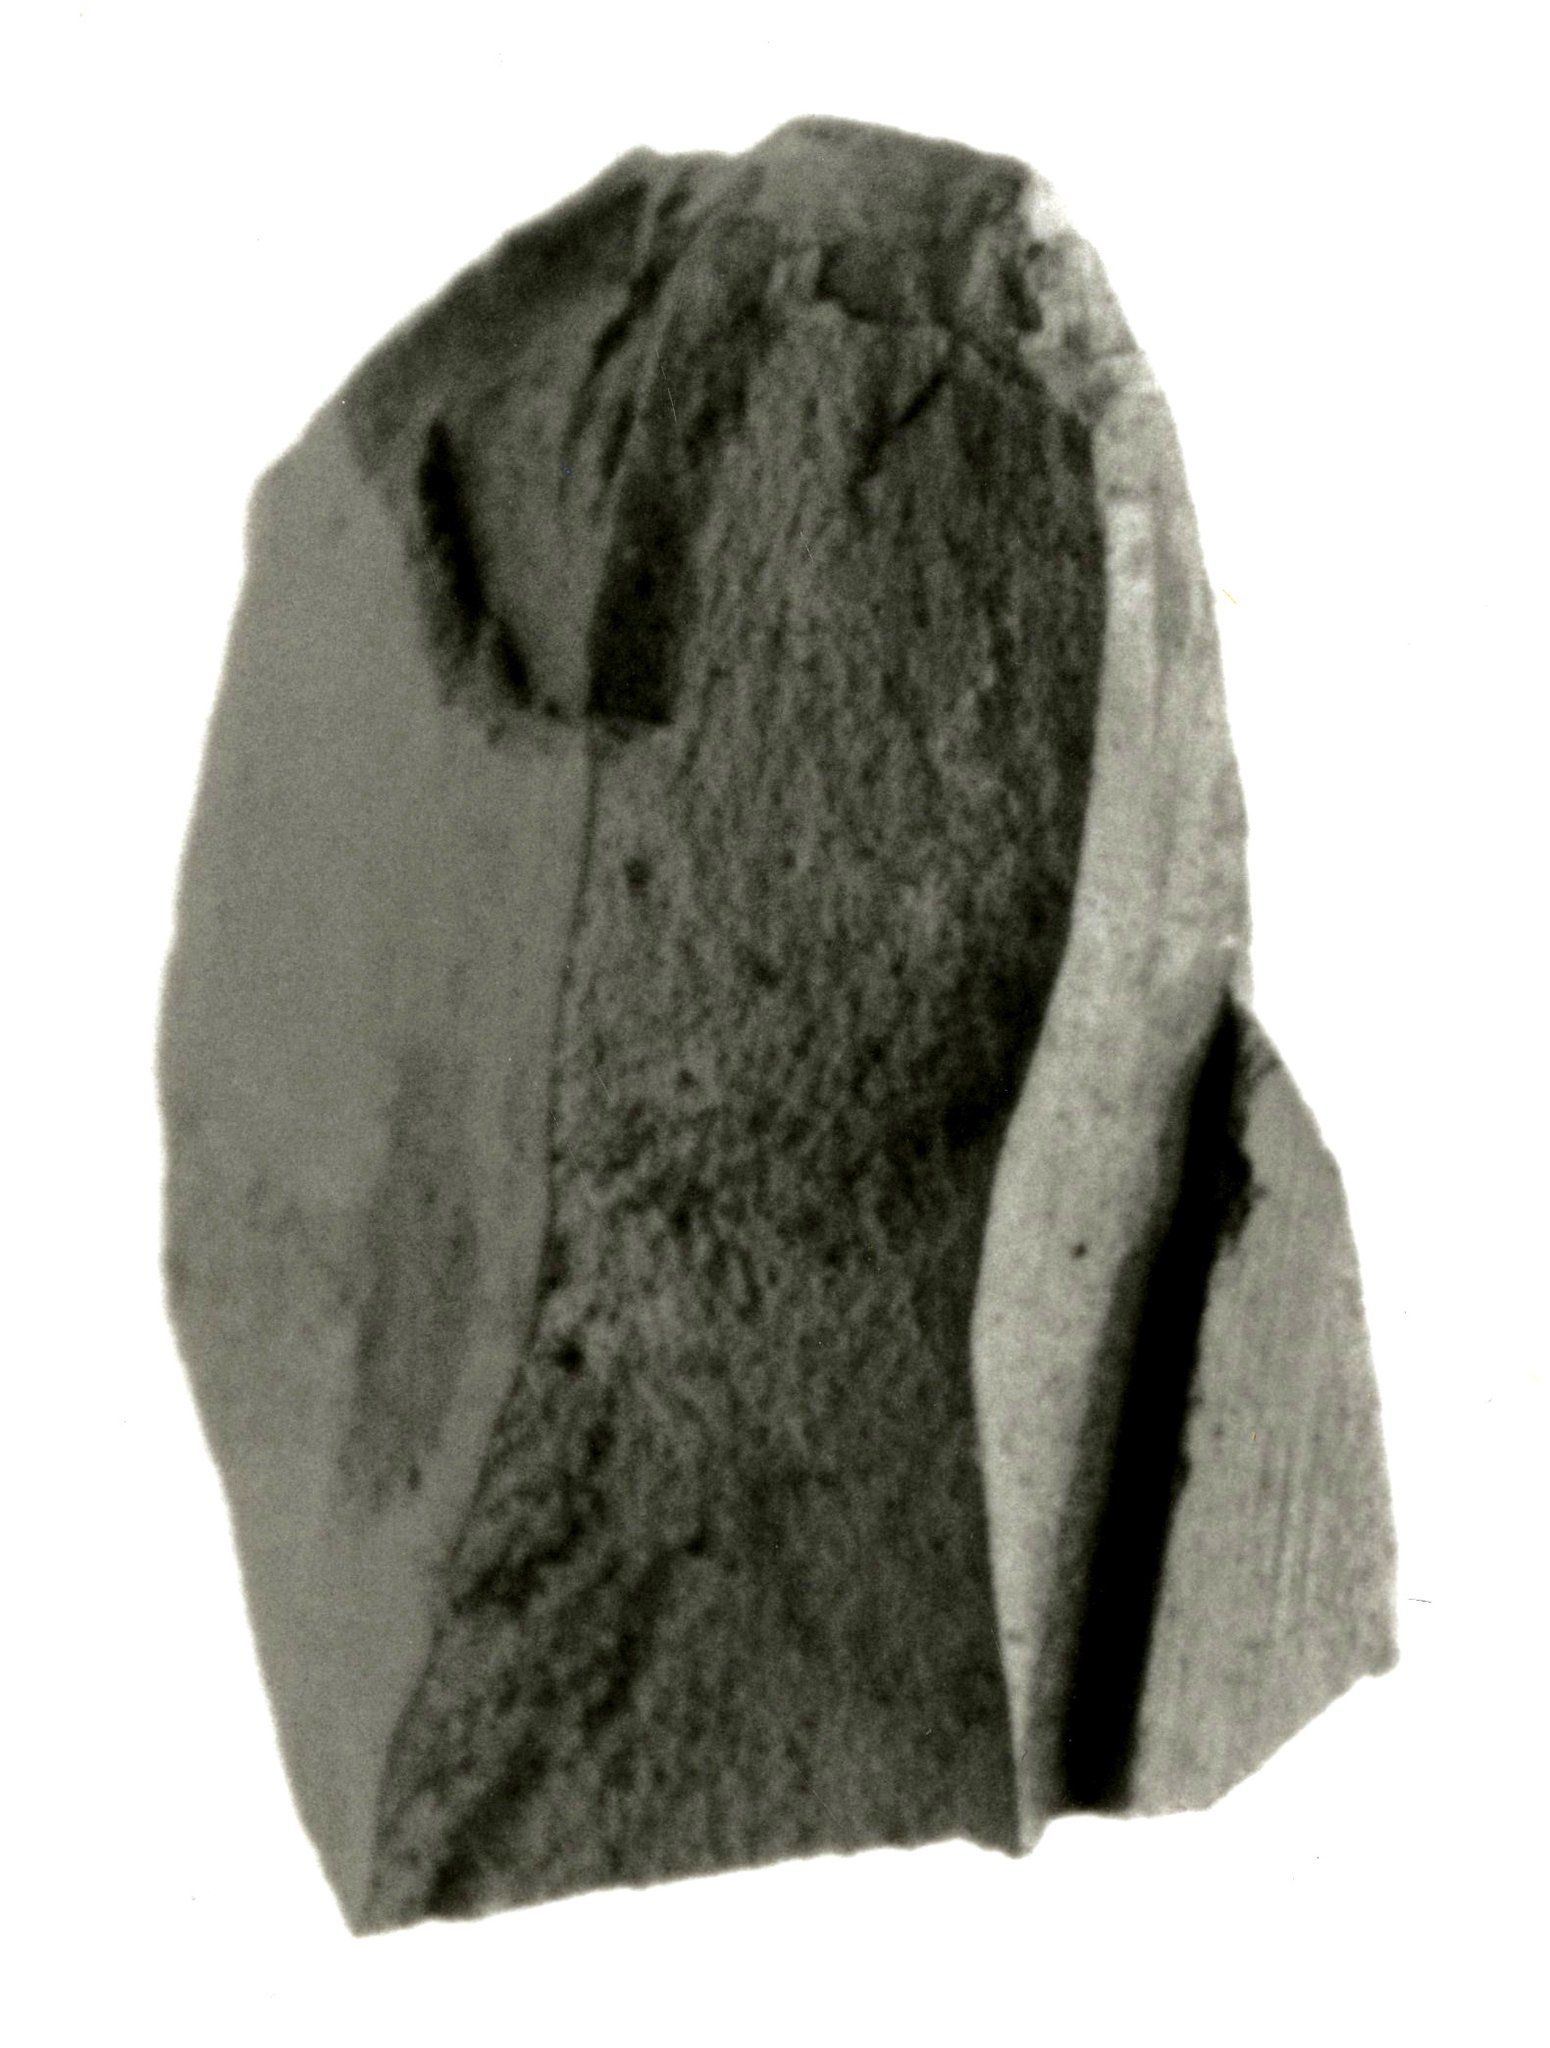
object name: relief, tomb of nespekashuty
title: Raised relief fragment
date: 664-610 BCE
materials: limestone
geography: egypt